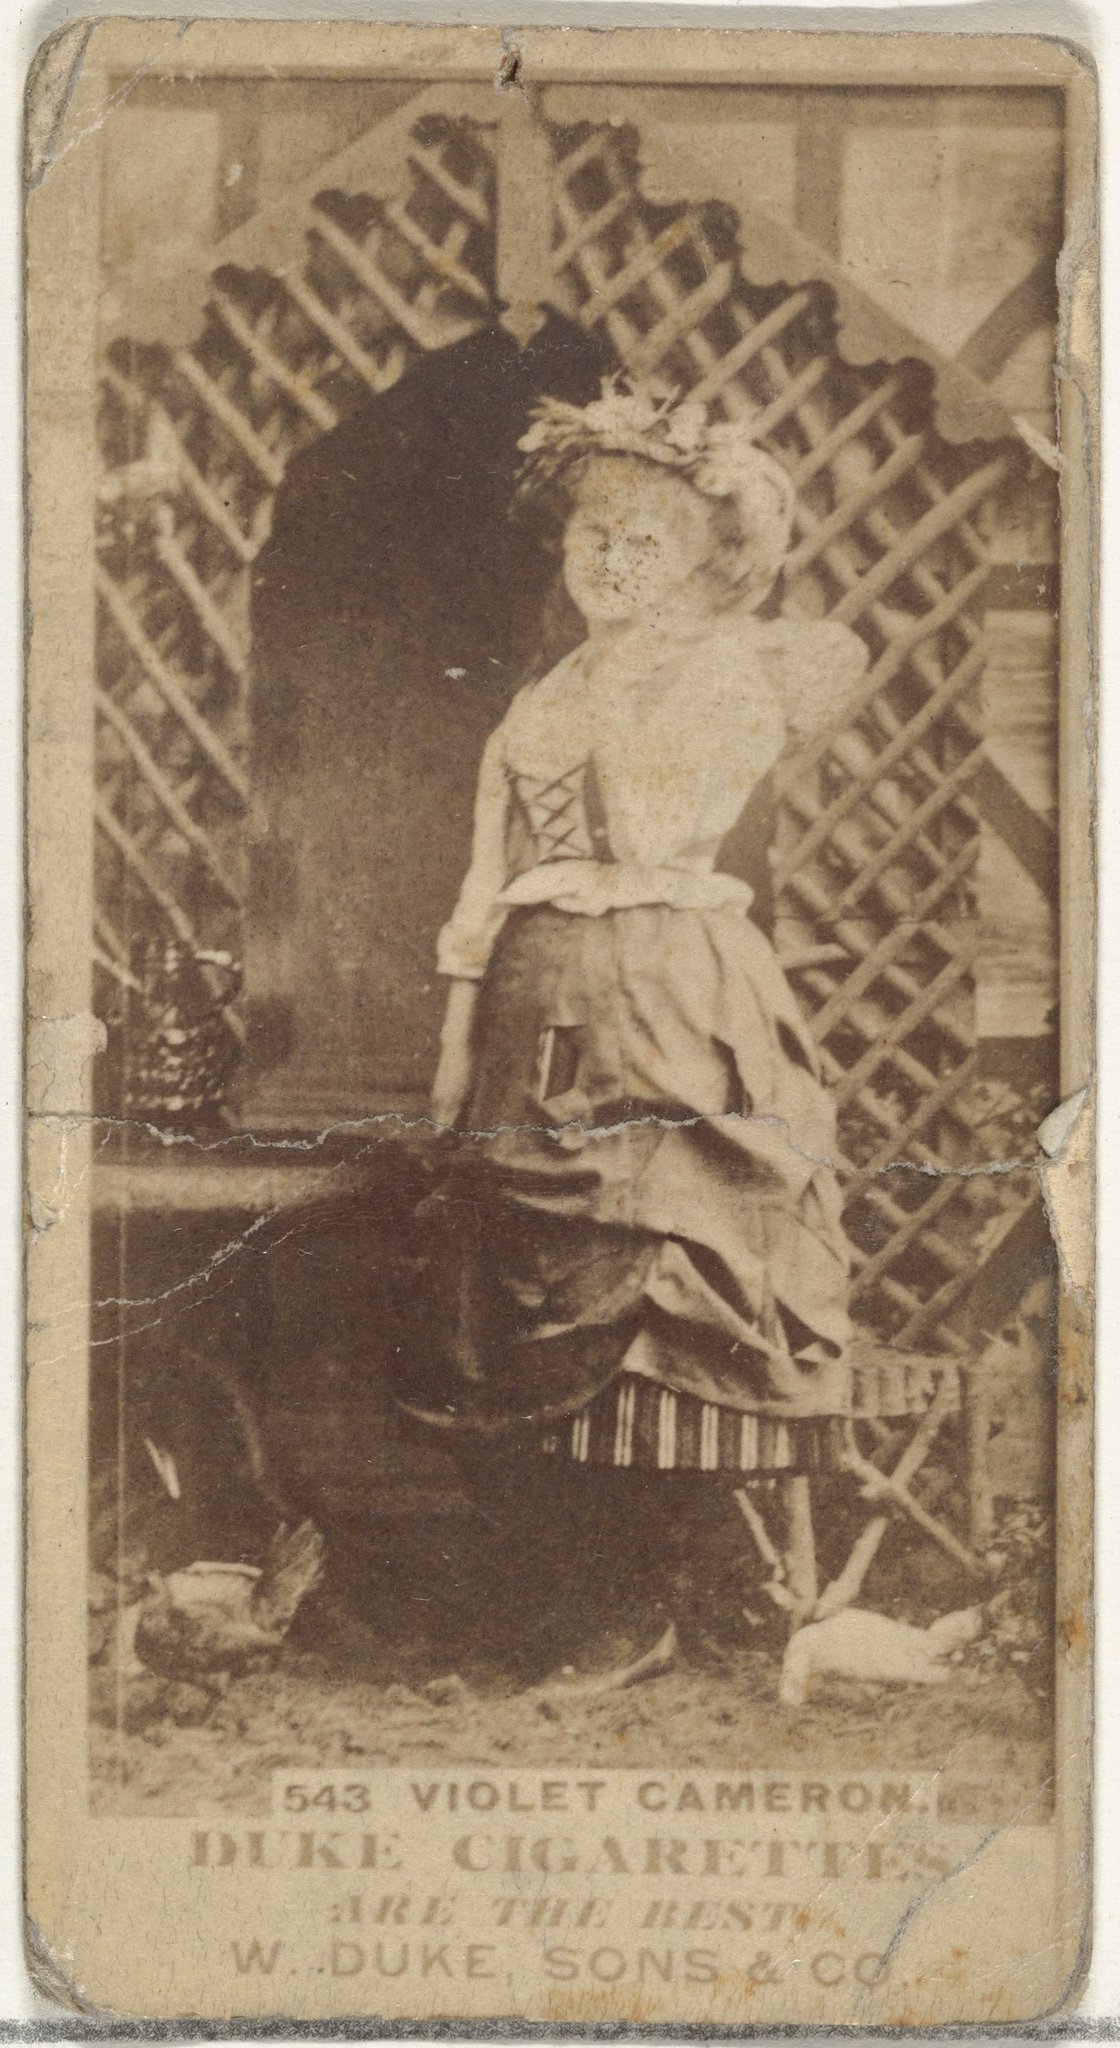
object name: photograph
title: Card Number 543, Violet Cameron, from the Actors and Actresses series (N145-7) issued by Duke Sons & Co. to promote Duke Cigarettes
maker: w. duke, sons & co.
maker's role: publisher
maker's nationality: american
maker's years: 1870-1920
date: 1880-1889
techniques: albumen silver print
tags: portraits,women,actresses